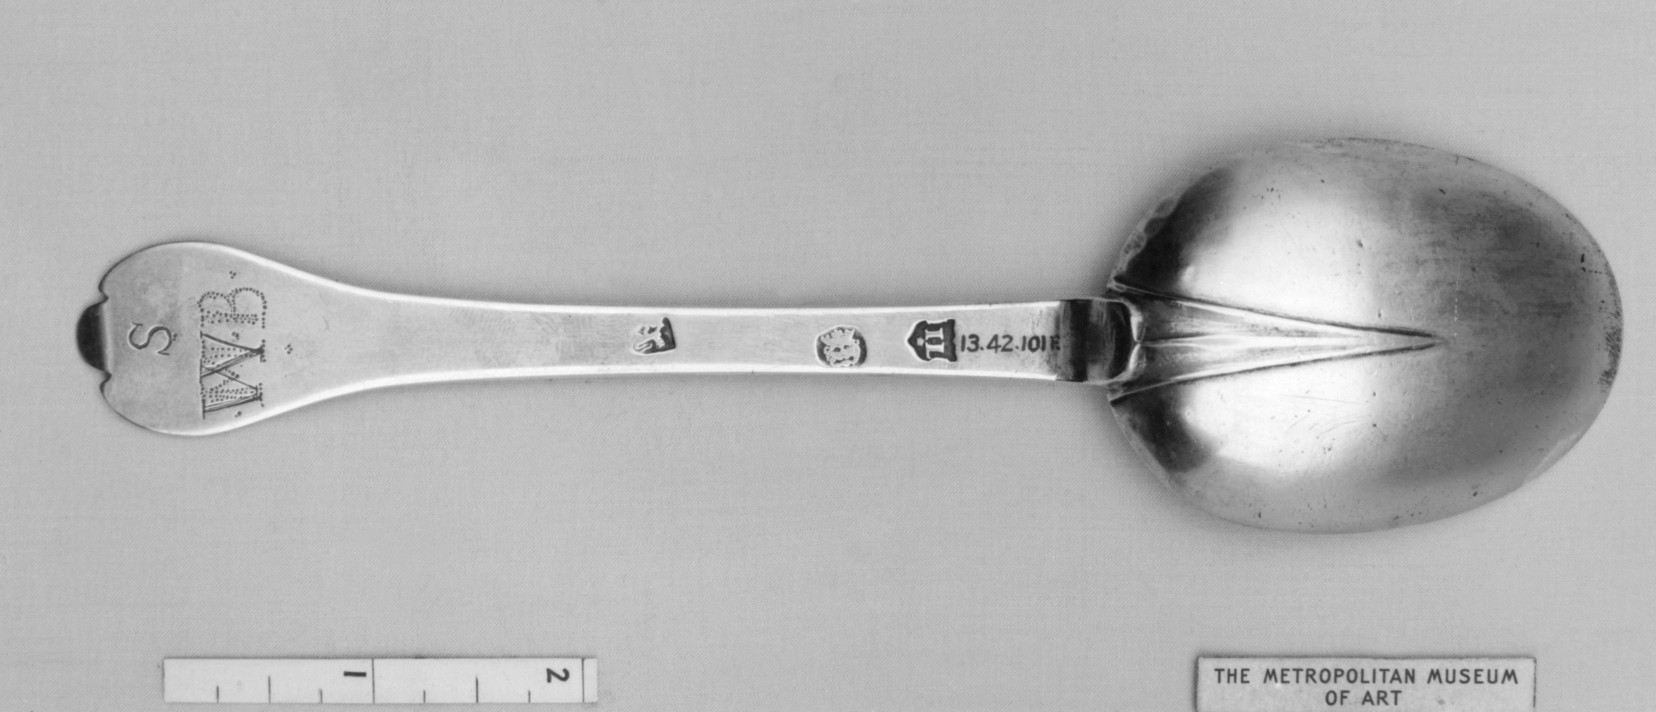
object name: spoon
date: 1670-1690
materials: silver